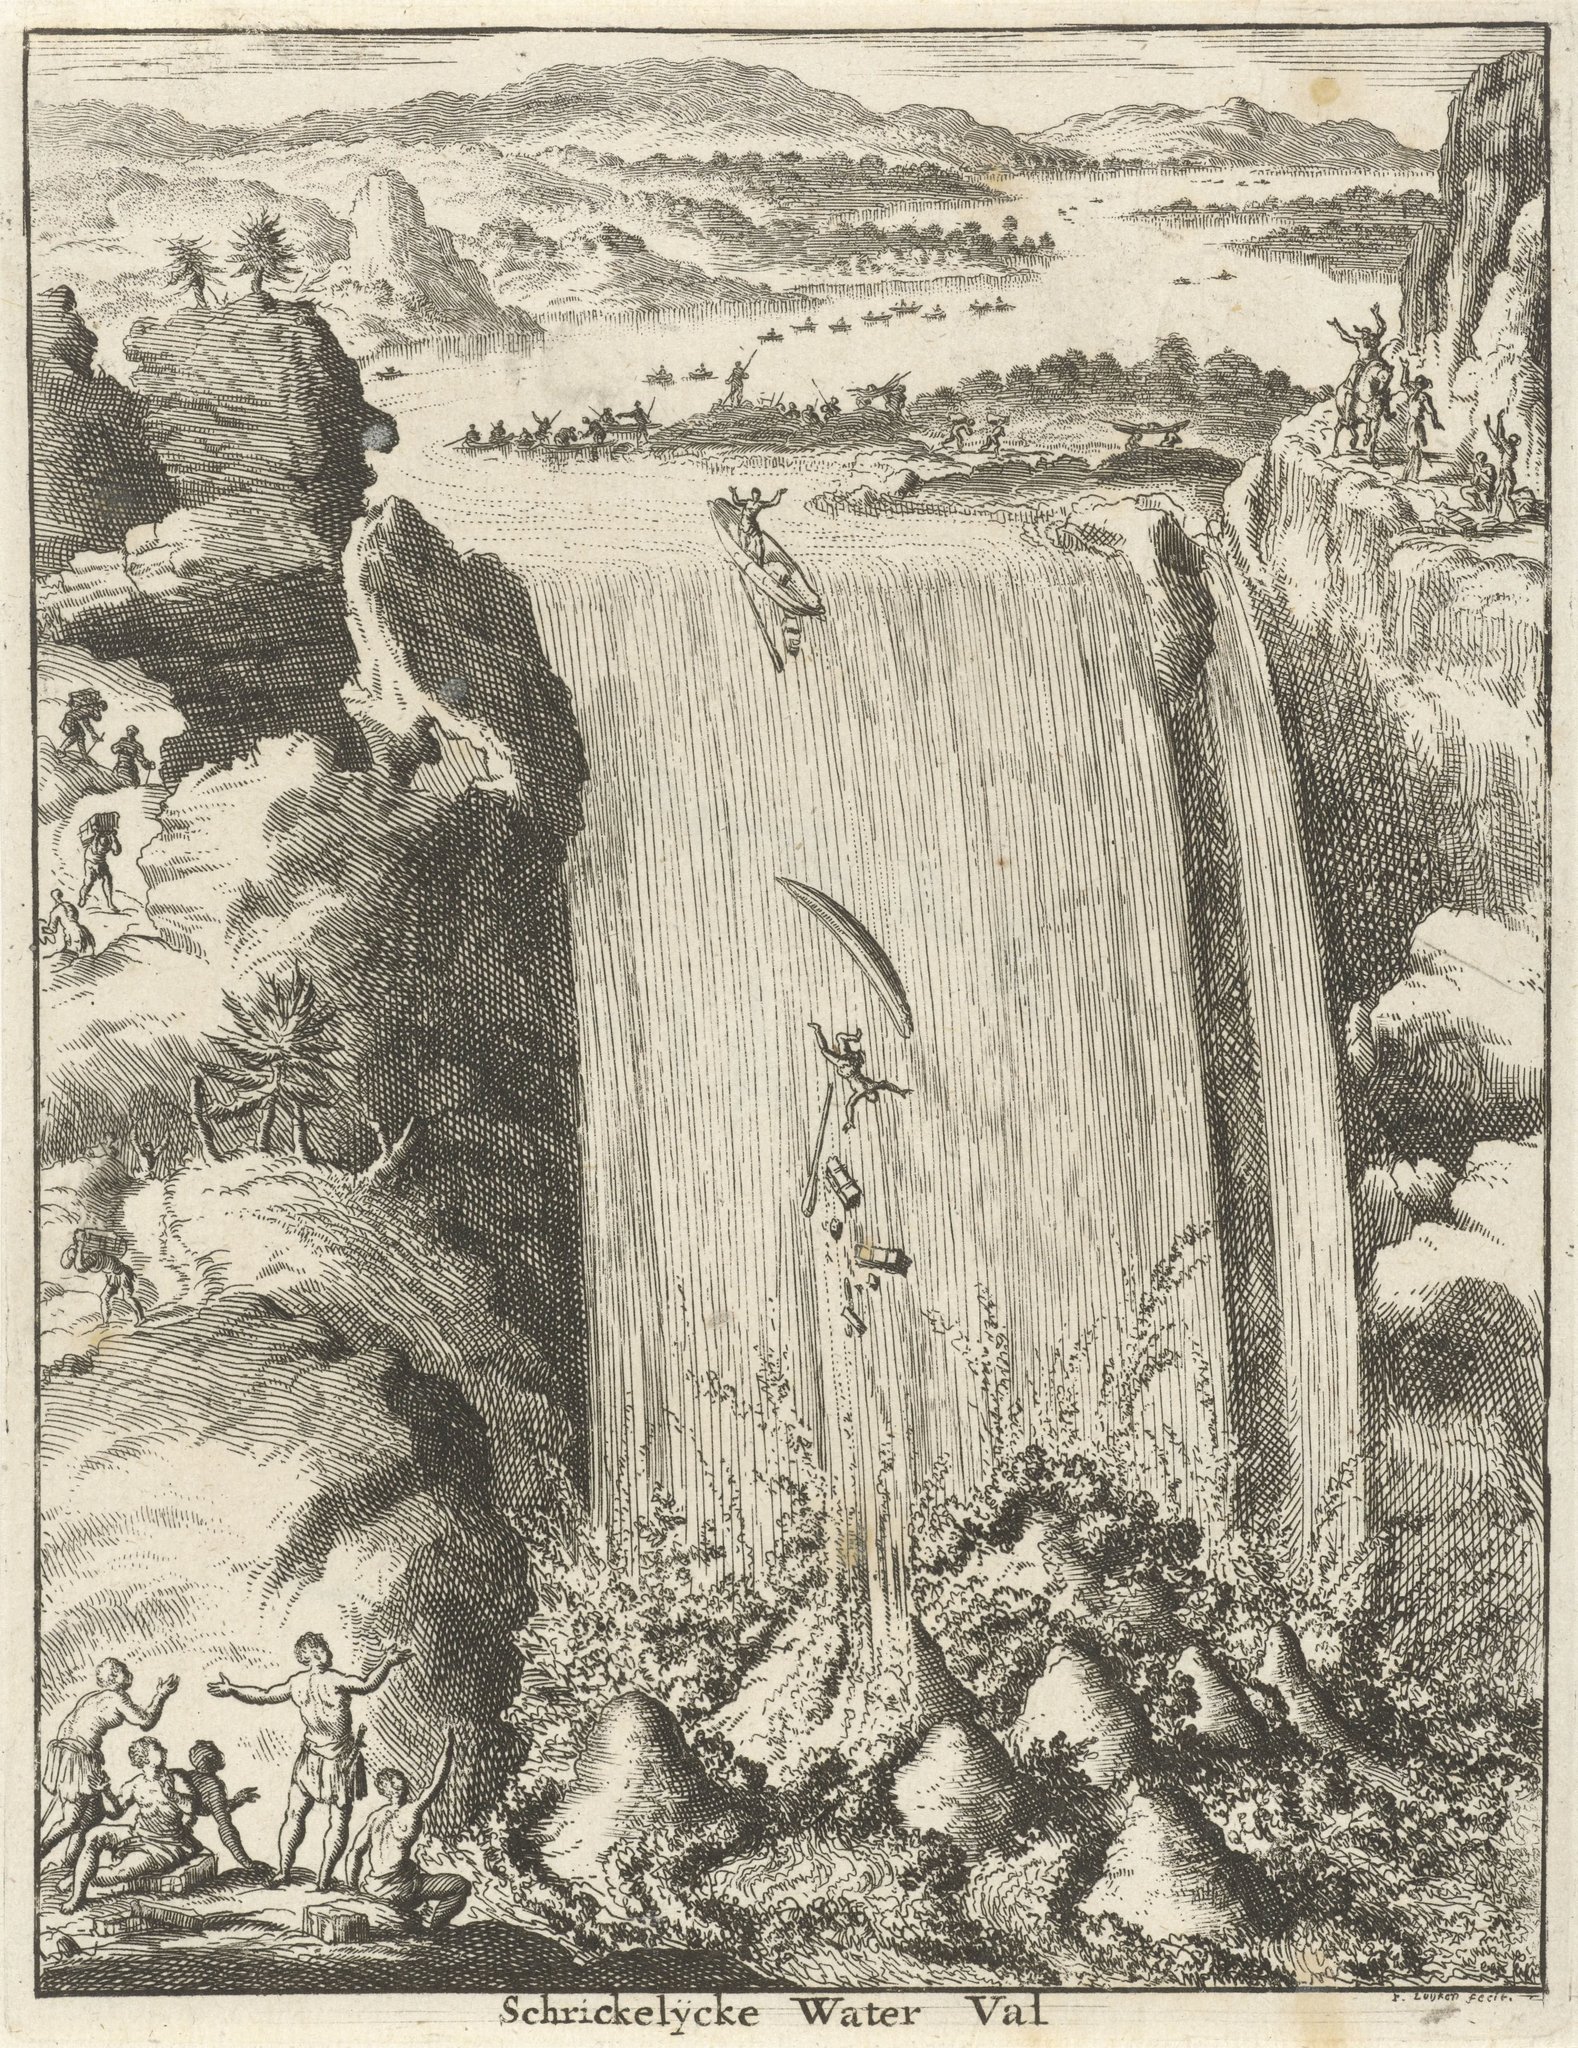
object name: book illustration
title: Schrickelijcke Water Val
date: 1681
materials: paper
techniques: etching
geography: amsterdam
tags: drowned person, canoeing, waterfall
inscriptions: collector's mark: Lugt 2228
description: Illustratie opgenomen in: Melton, Edward. Zeldzaame en gedenkwaardige zee- en landreizen, p. 141. Amsterdam: Jan Claesz ten Hoorn, 1681.